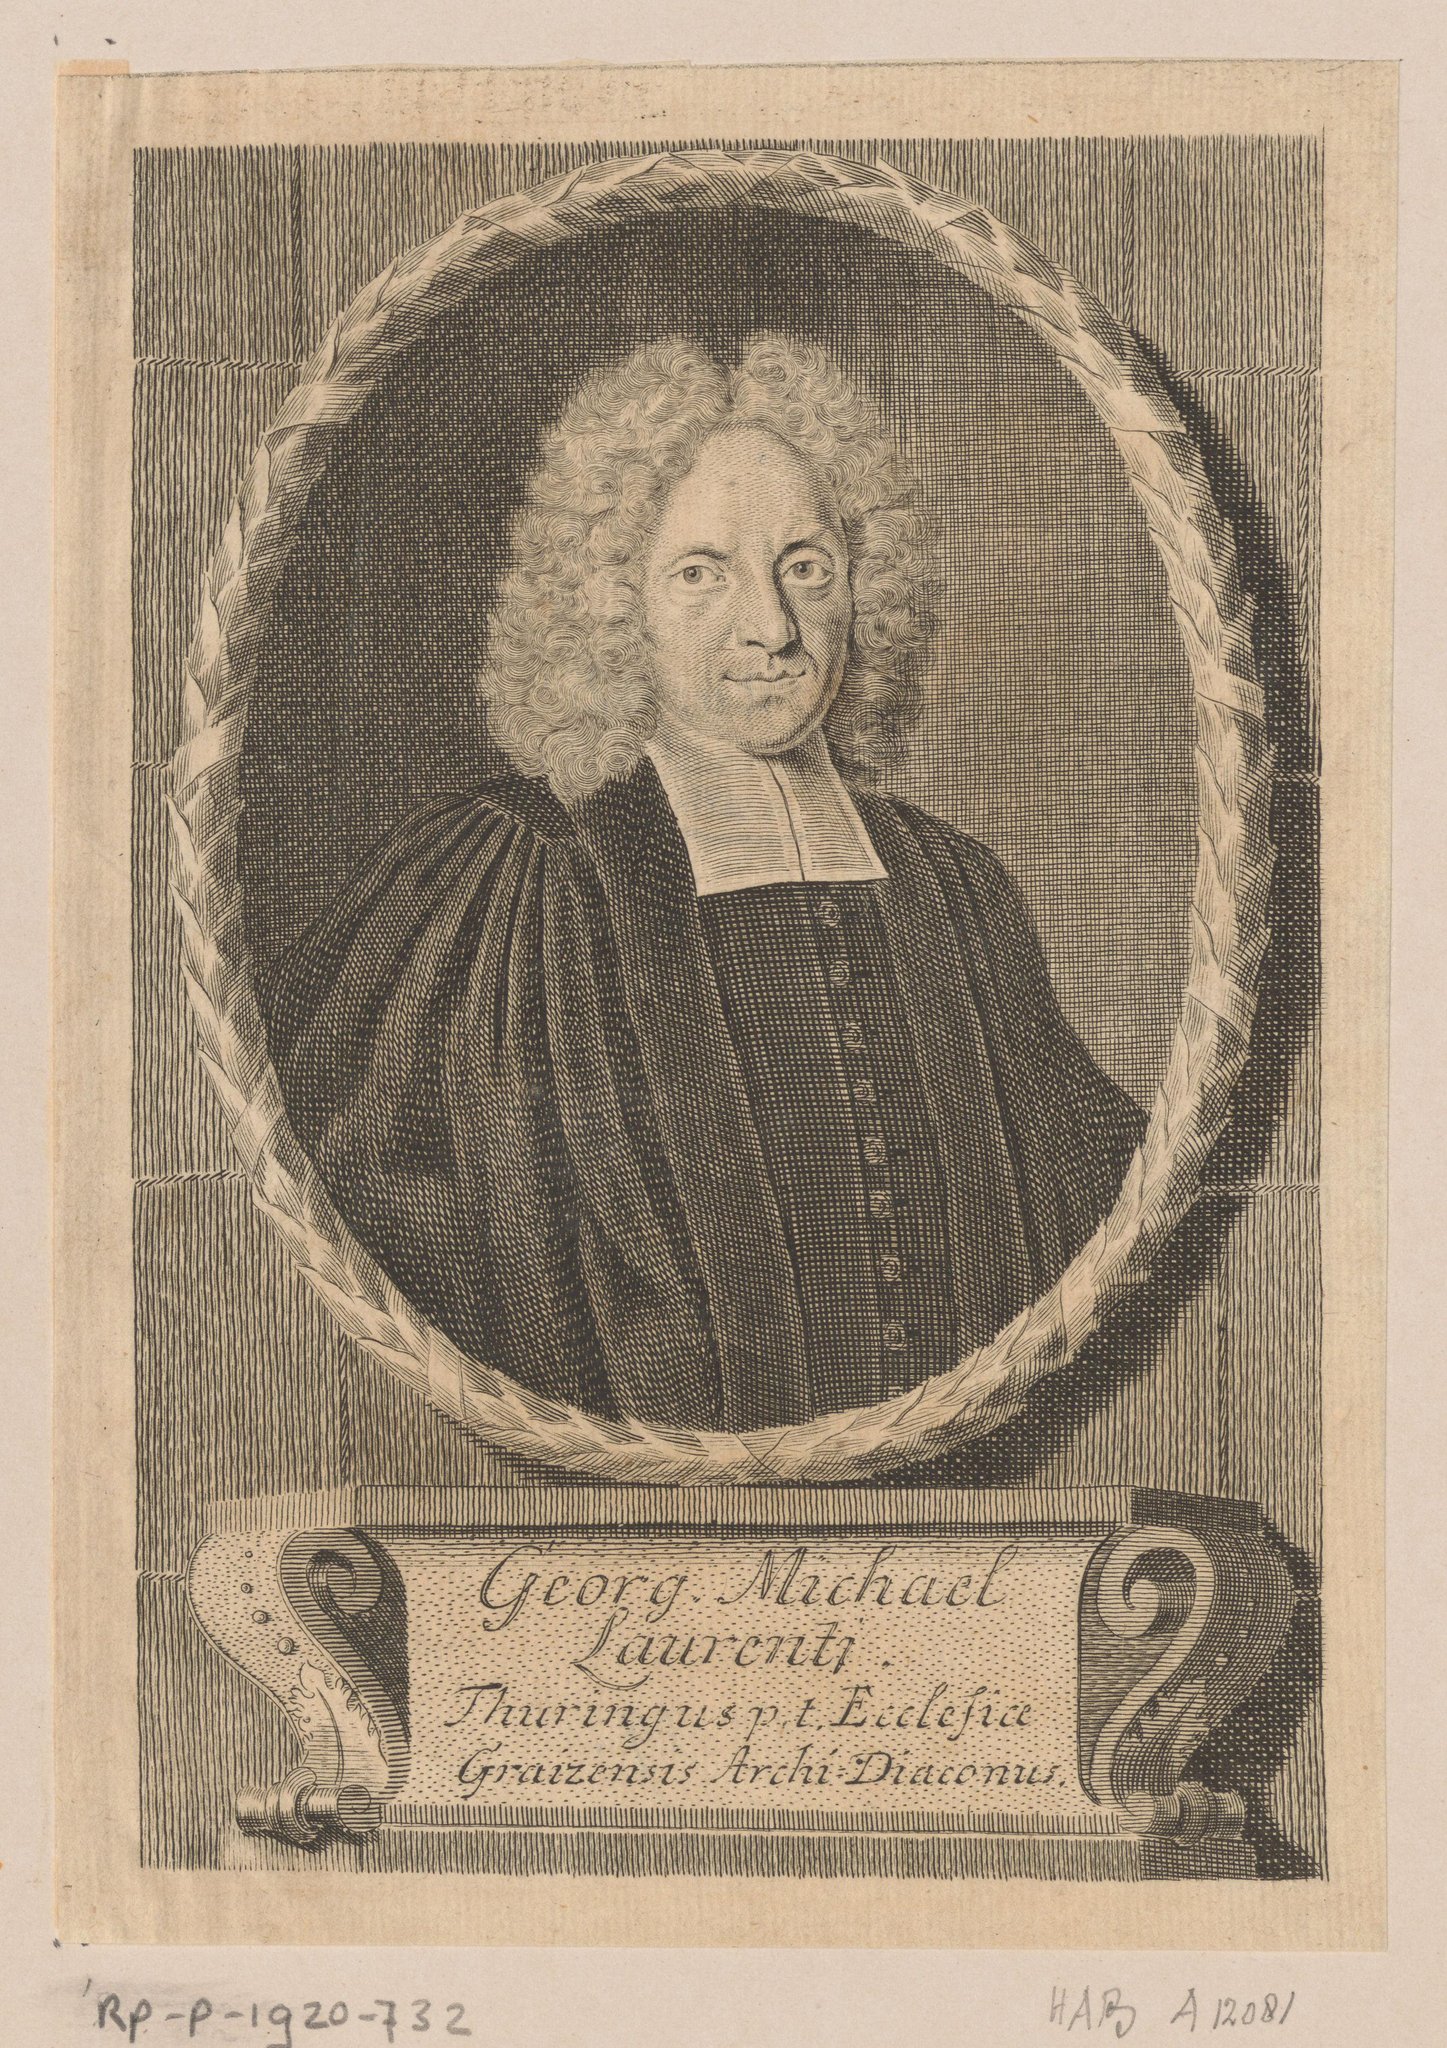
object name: print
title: Portret van Georg Michael Laurentii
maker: martin bernigeroth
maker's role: print maker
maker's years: 1670-1733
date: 1720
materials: paper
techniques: engraving, etching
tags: clergyman, historical persons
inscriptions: collector's mark: Lugt 2228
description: Prent waarschijnlijk uit: Laurentii, Georg Michael. Kurtze Erklärung des Evangelii St. Matthäi (...). Halle: Waisenhaus, 1720.